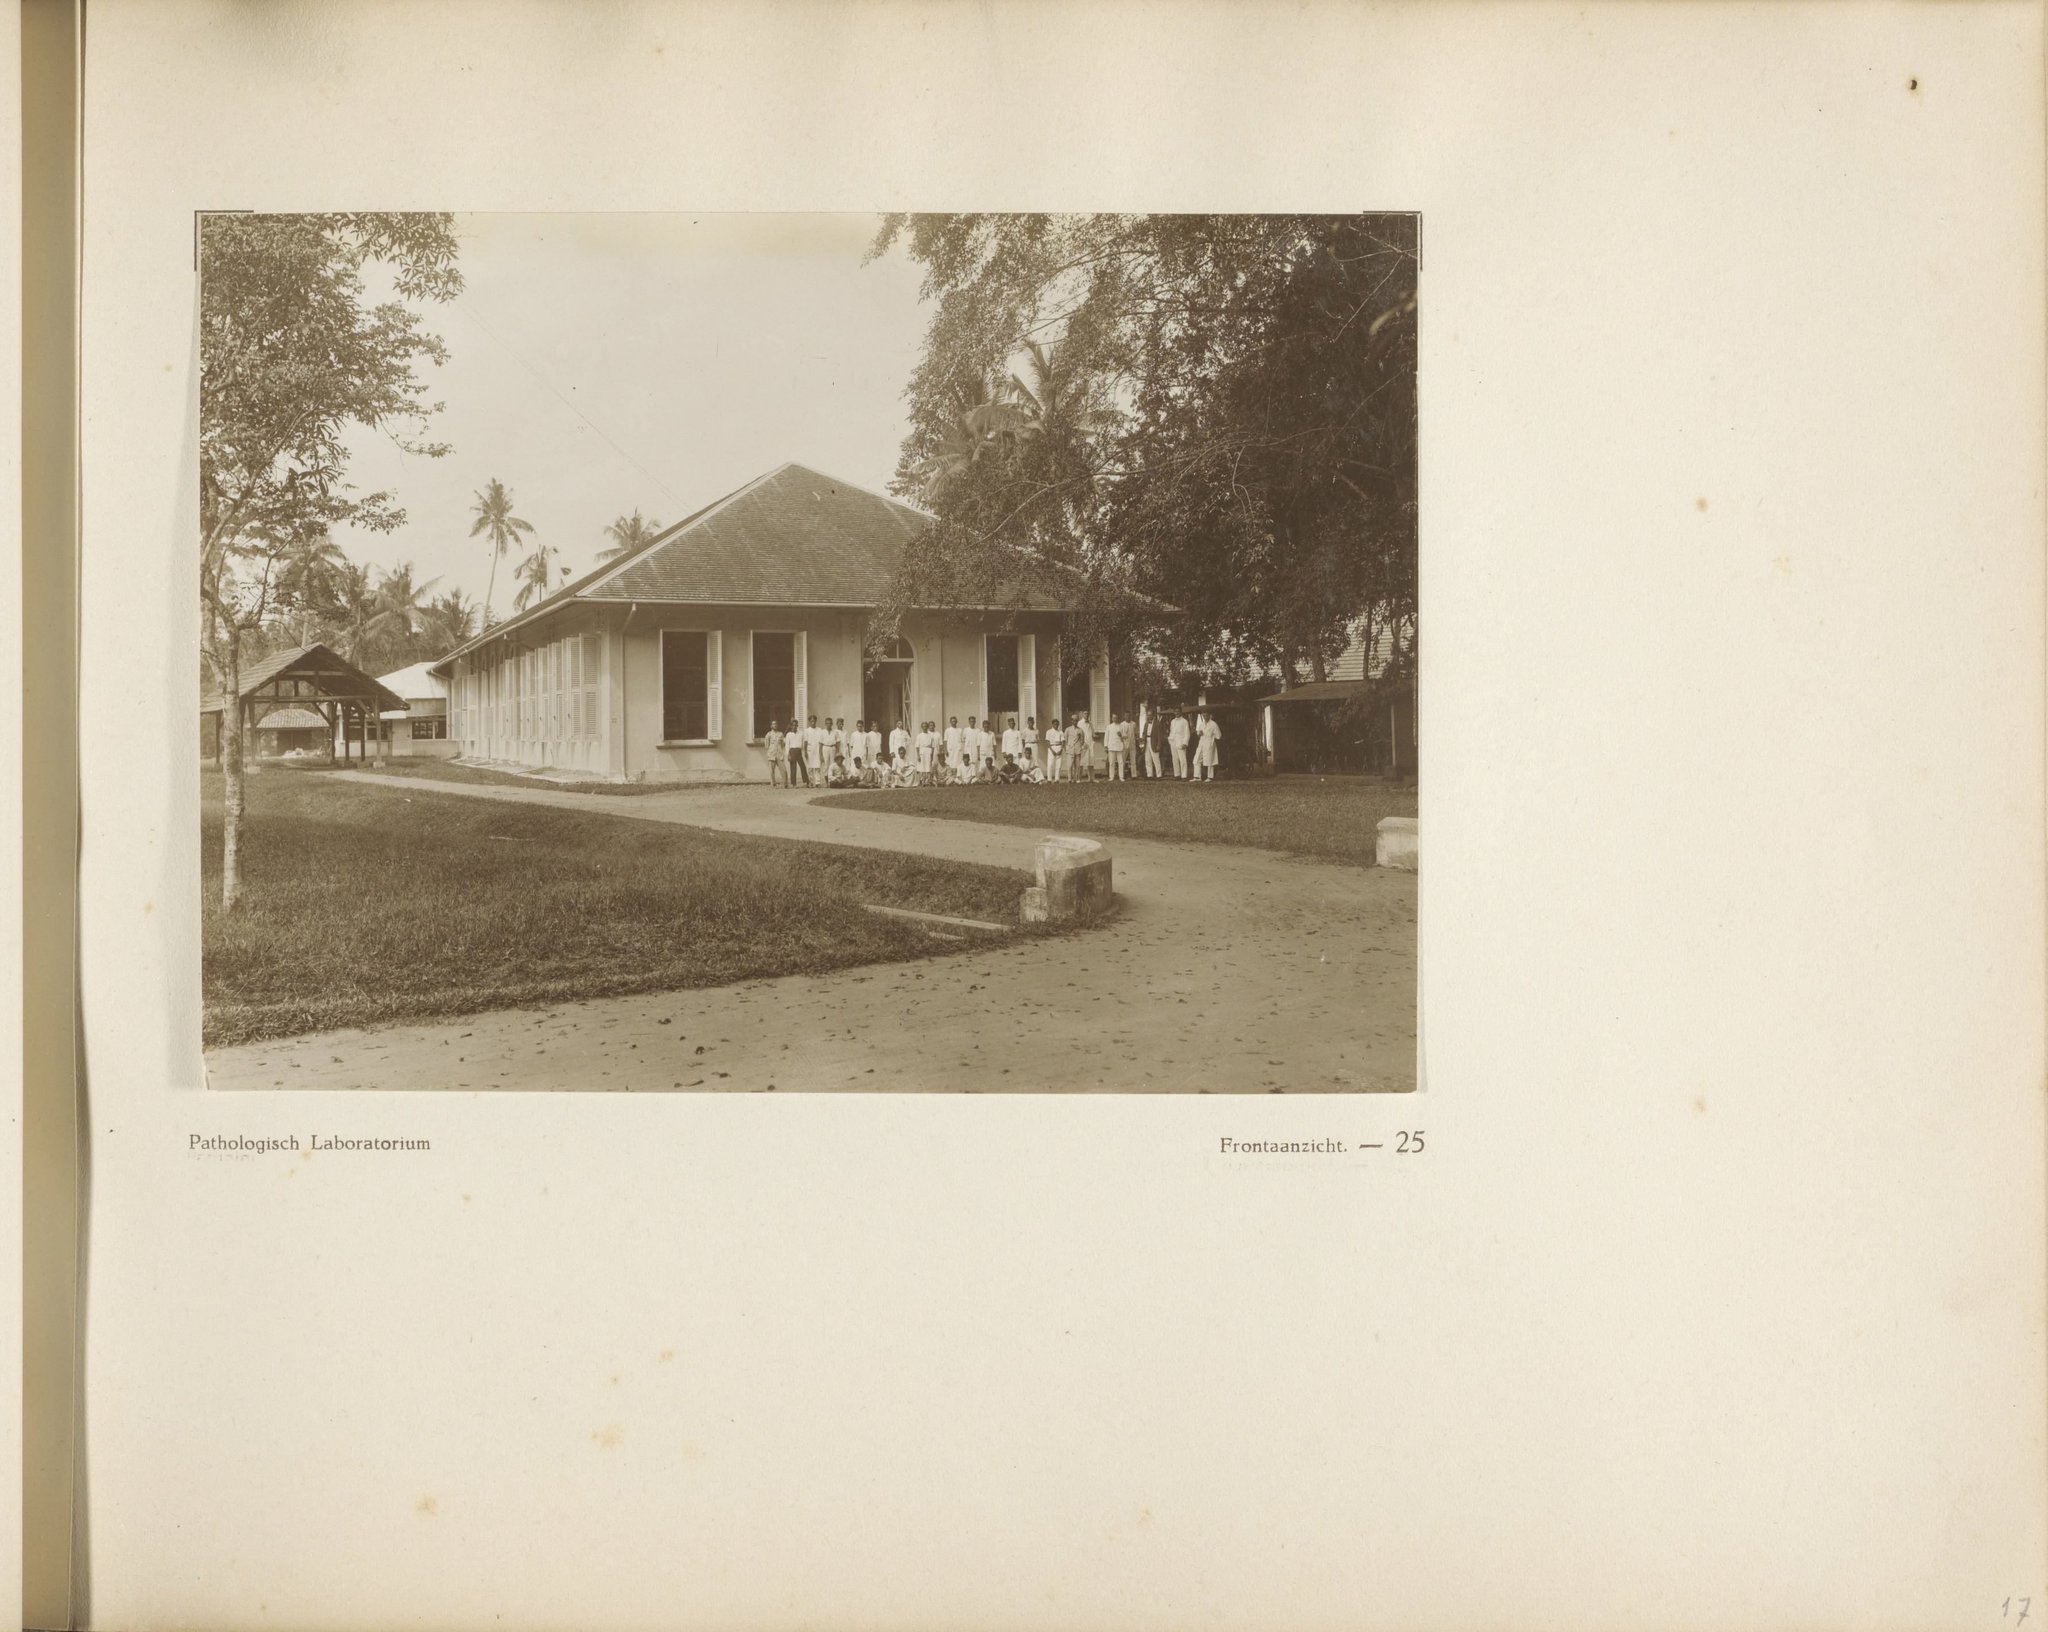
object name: photograph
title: Pagina 25 van fotoboek van de Algemeene Vereeniging van Rubberplanters ter Oostkust van Sumatra (A.V.R.O.S.)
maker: j.w. meyster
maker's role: fotograaf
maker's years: 1887-1945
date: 1924-1925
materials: paper, photographic support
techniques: printing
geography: sumatra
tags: (non-fruit) products of plants or trees: rubber, laboratory, sumatra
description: Boekpagina met een foto van de personeel staand aan de voorzijde van het Pathologische Laboratorium van het Algemeen Proefstation van de Algemeene Vereeniging van Rubberplanters ter Oostkust van Sumatra (A.V.R.O.S.) te Kampong Baroe. Onderdeel van een fotoboek van de Algemeene Vereeniging van Rubberplanters ter Oostkust van Sumatra (A.V.R.O.S.).